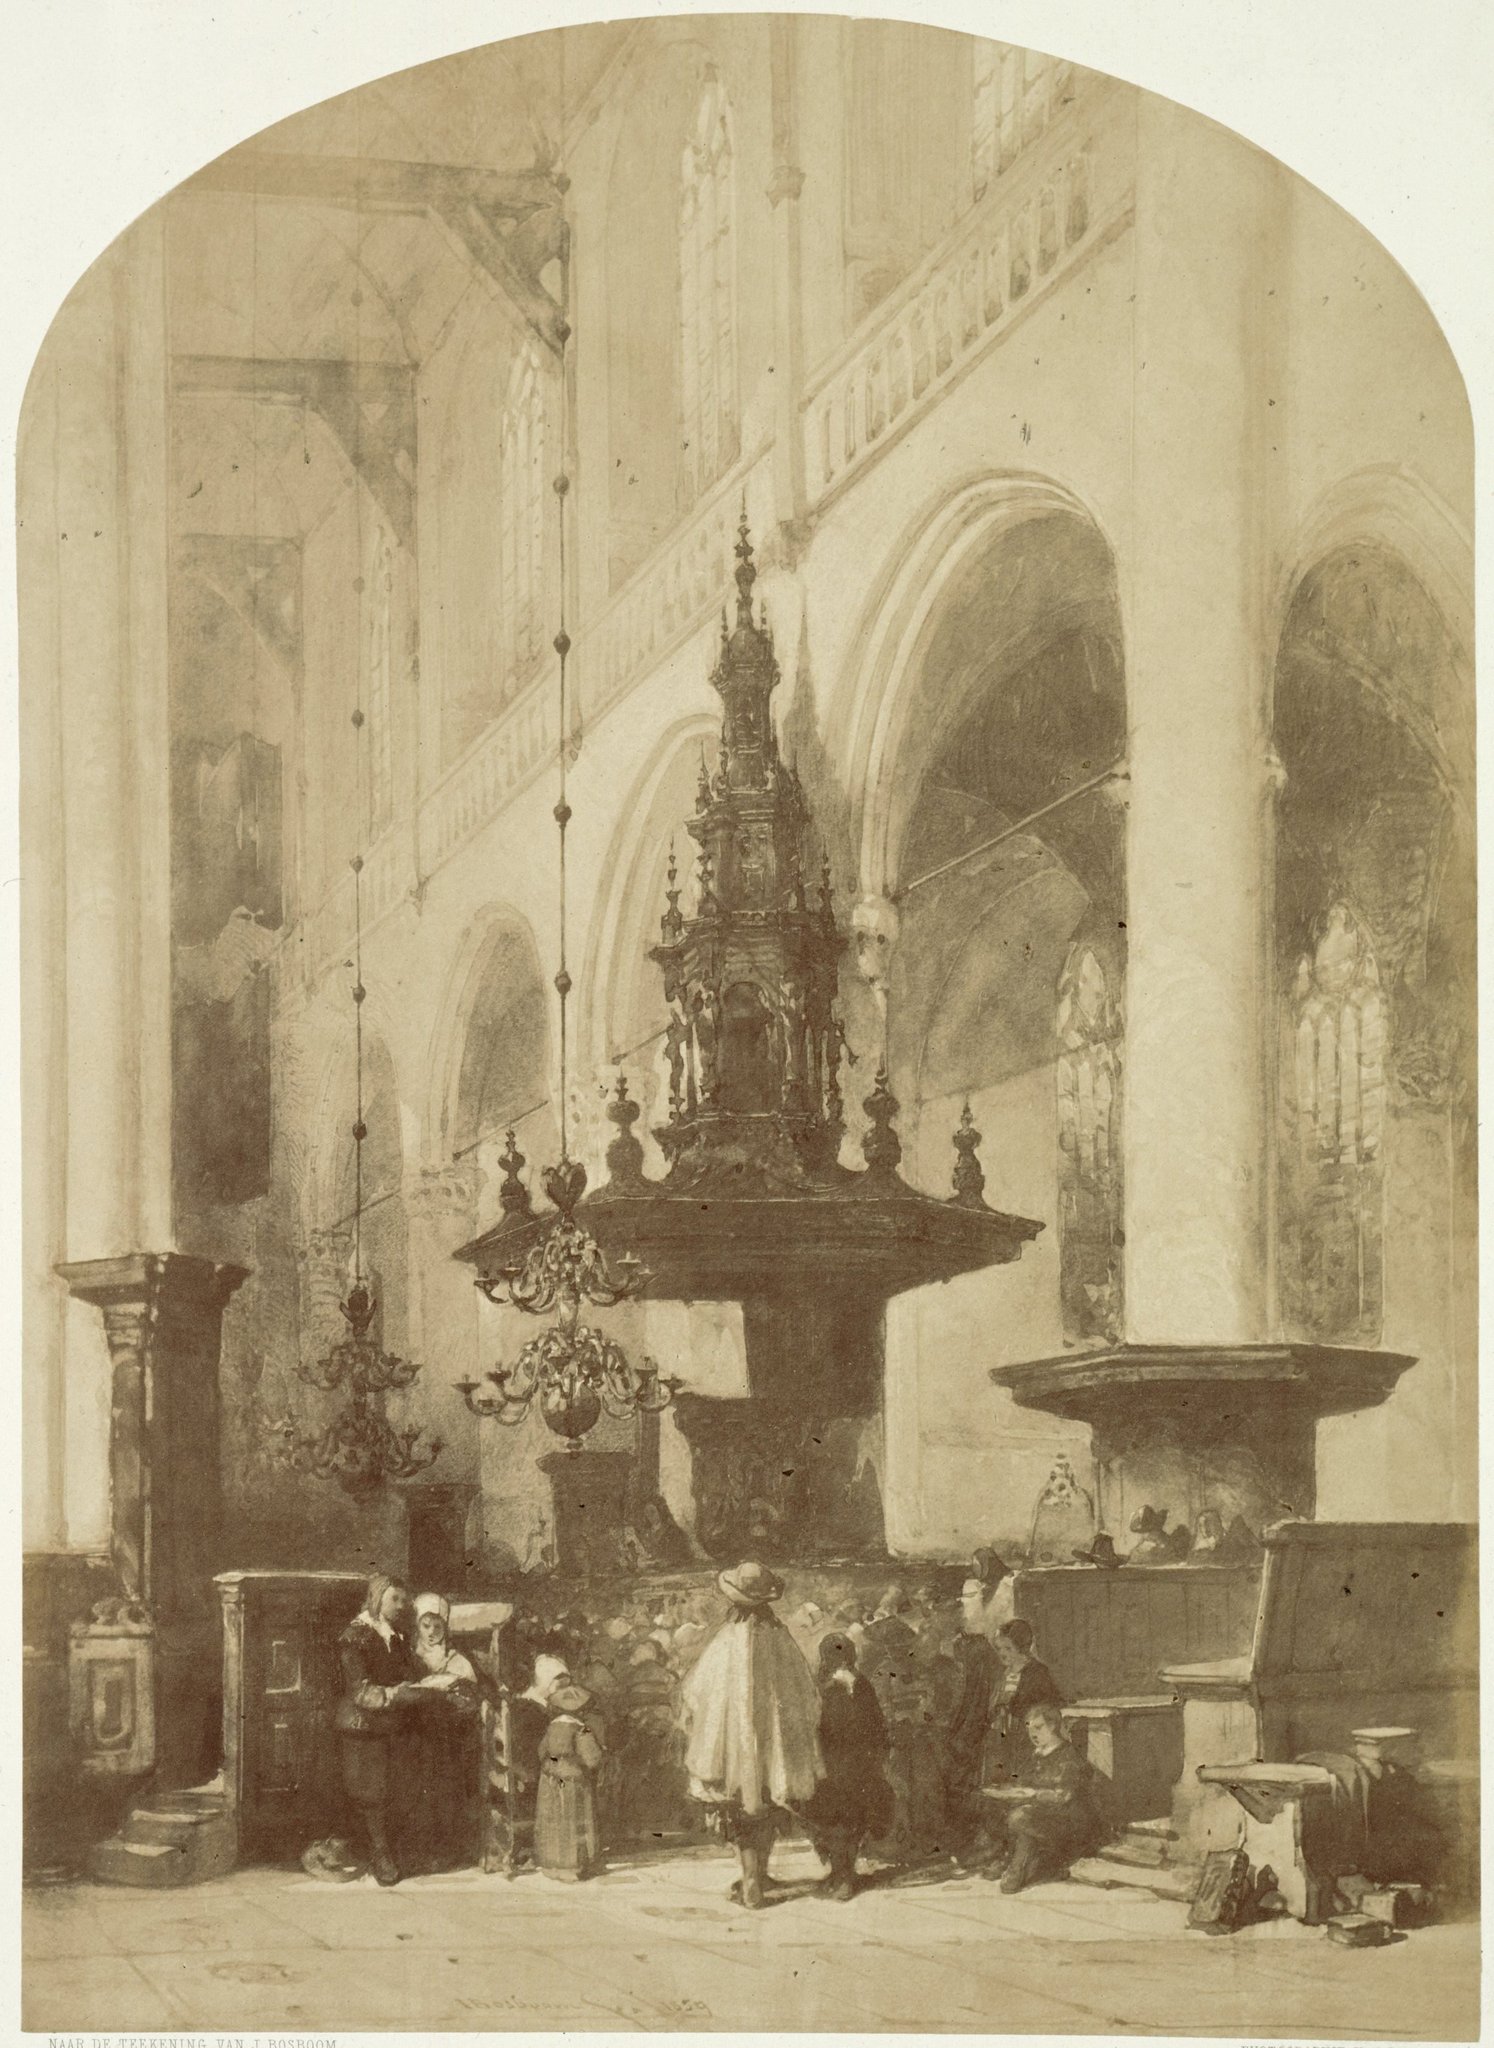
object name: reproduction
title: Fotoreproductie van een tekening van Johannes Bosboom van het interieur van de Nieuwe Kerk in Amsterdam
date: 1859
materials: cardboard, paper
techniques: albumen print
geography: haarlem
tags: interior of church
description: Bij de fotoreproductie hoort een tekst bestaande uit zes losse bladen, geschreven door J. van Lennep.